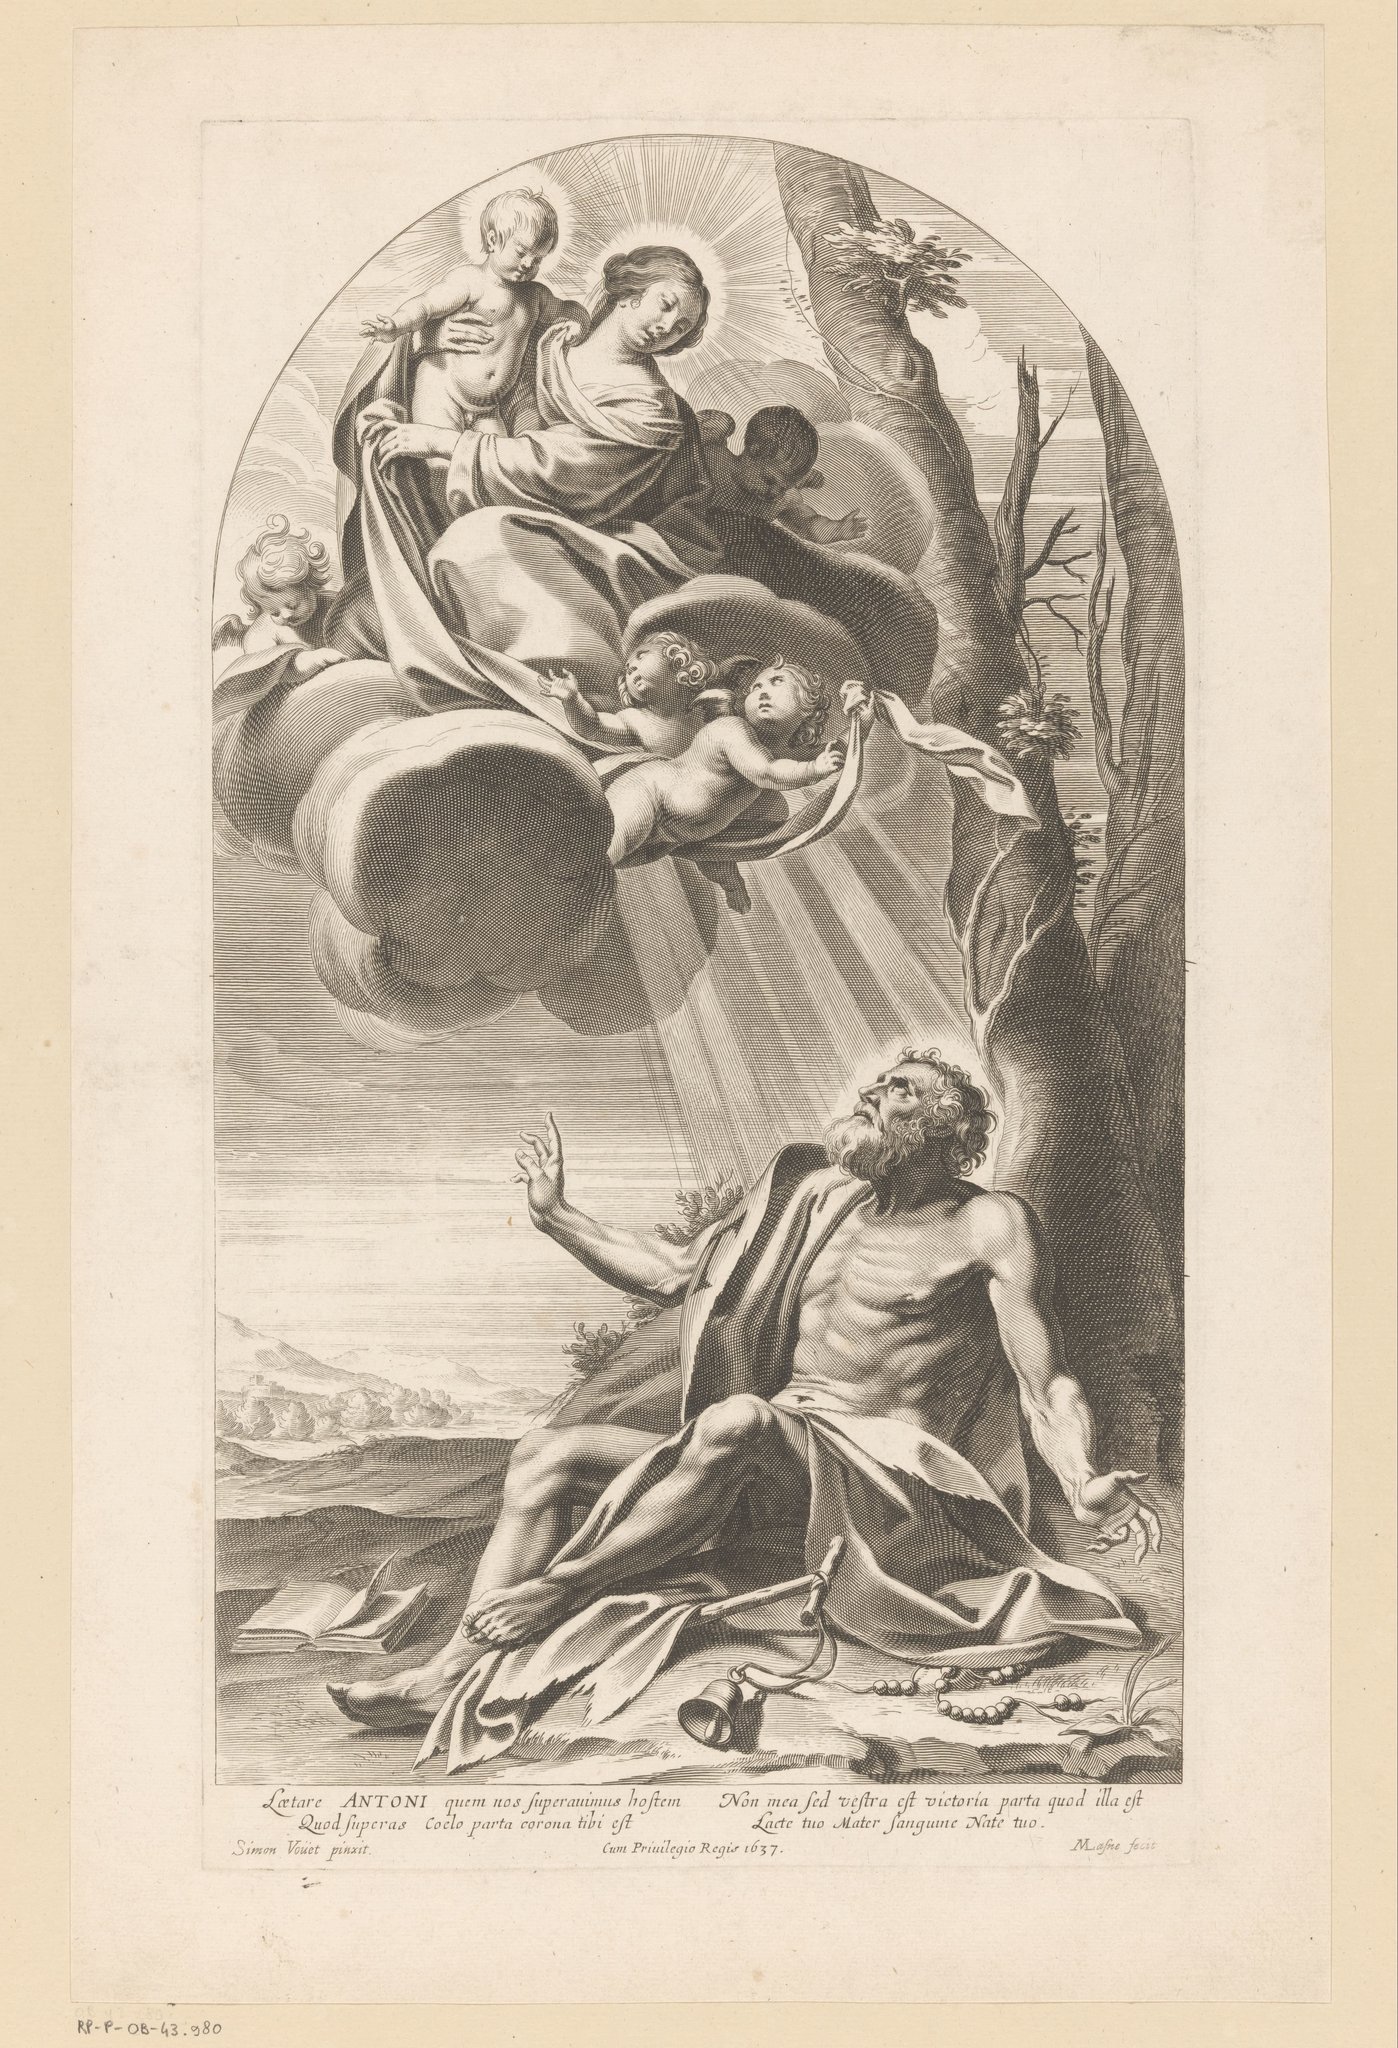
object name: print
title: Maagd verschijnt aan de H. Antonius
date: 1637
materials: paper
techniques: engraving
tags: st. antony abbot retreats into the desert, after having given away his possessions to the poor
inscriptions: collector's mark: Lugt 240